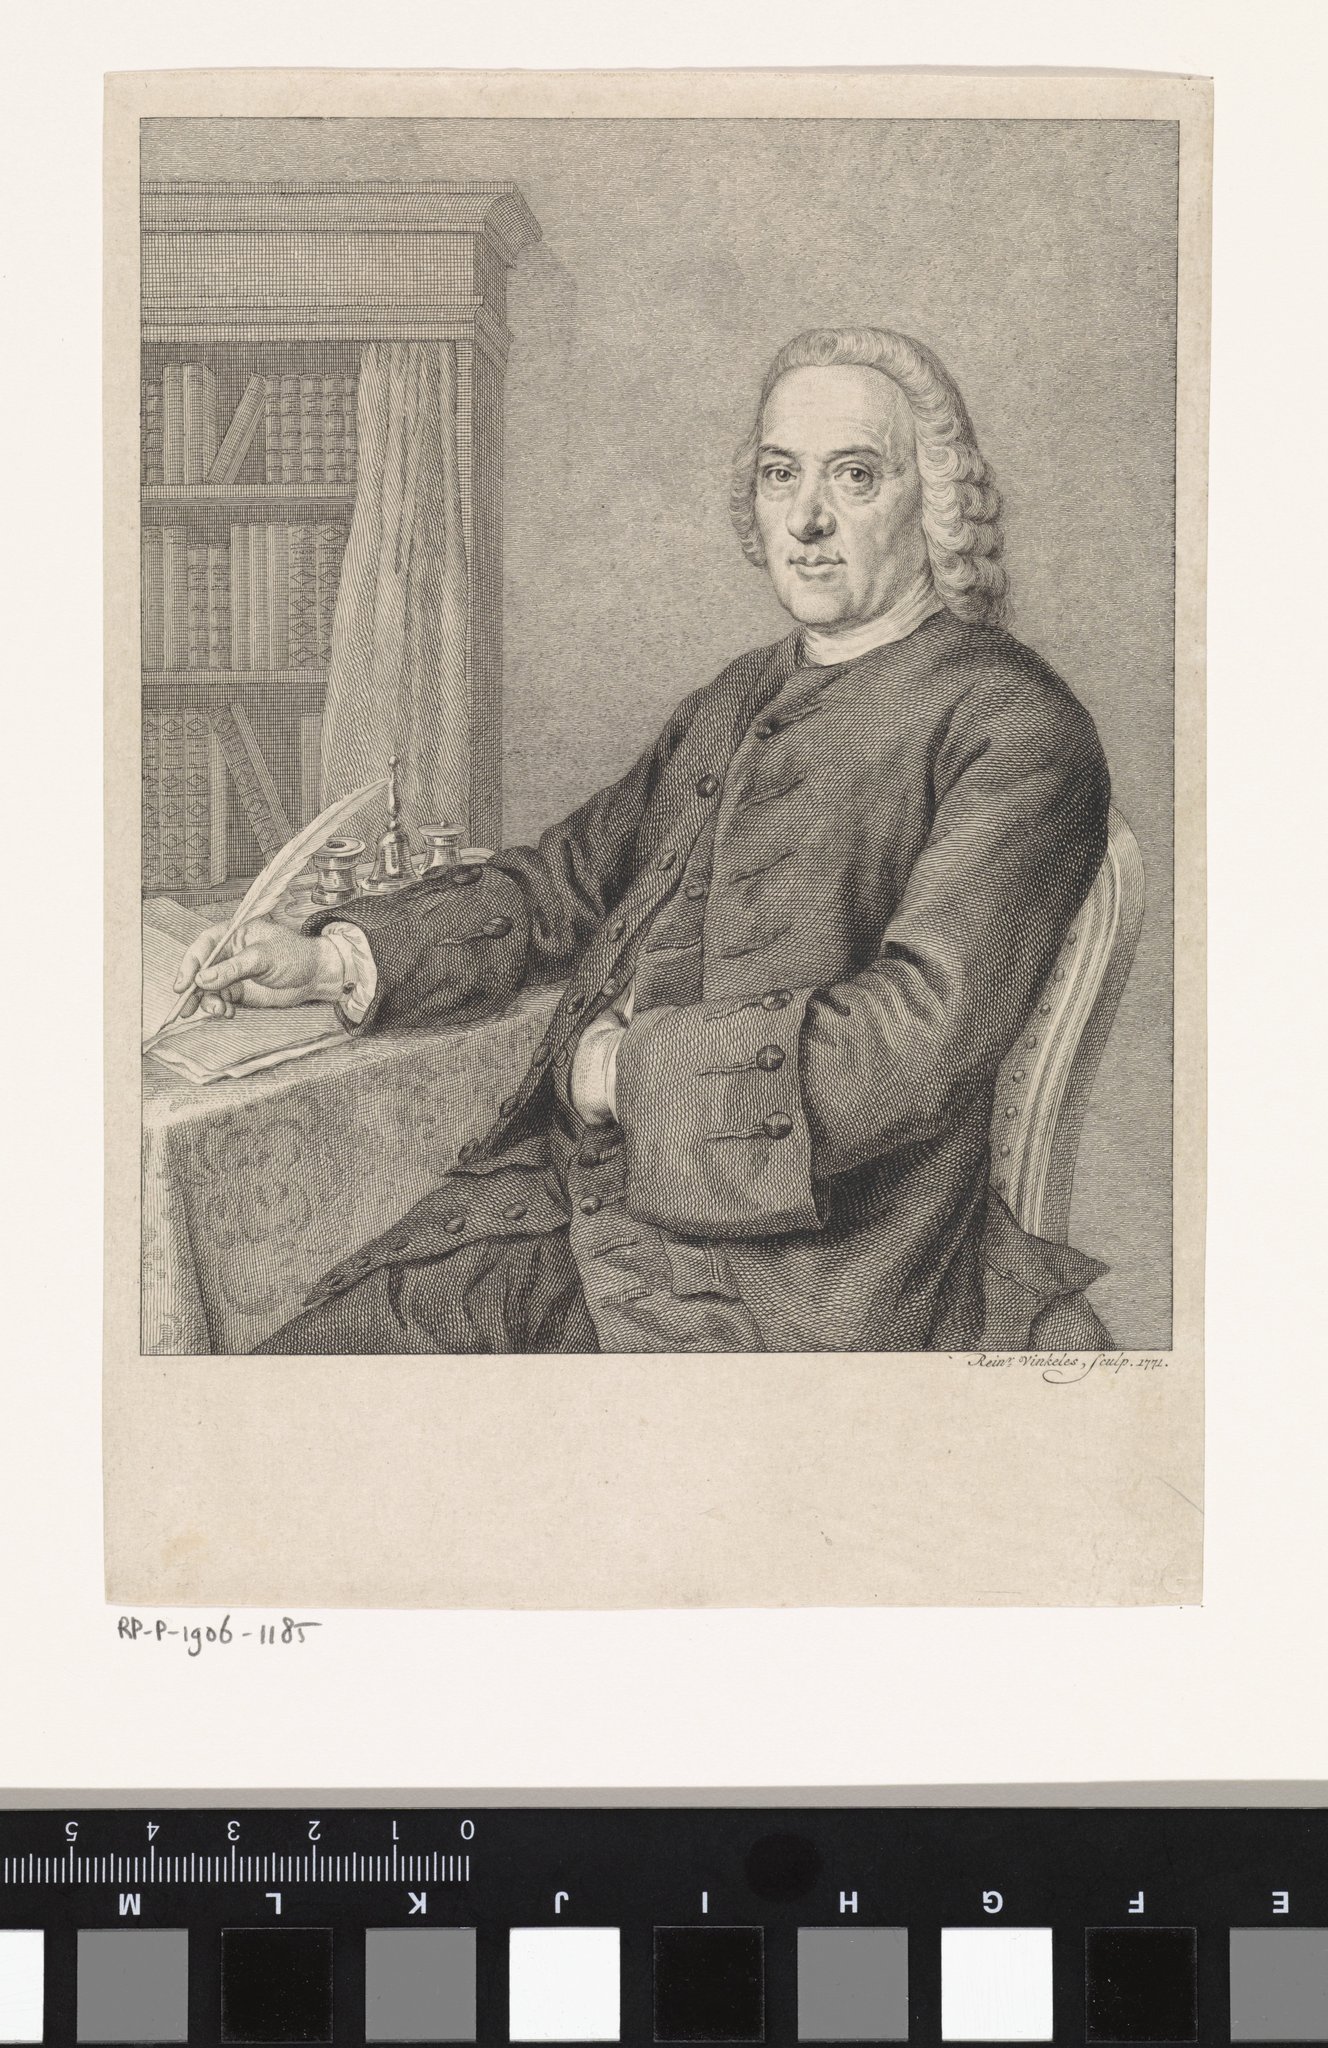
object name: print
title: Portret van Nikolaes Versteeg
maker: reinier vinkeles (i)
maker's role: draughtsman, print maker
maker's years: 1741-1816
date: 1771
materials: paper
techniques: engraving, etching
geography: amsterdam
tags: nikolaes versteeg, writing-table, writing-desk, quill, study; 'studiolo'; library, writing accessories, paper (writing material)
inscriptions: collector's mark: Lugt 2228, collector's mark: Lugt 1120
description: Portret van de Rotterdamse dichter Nikolaes Versteeg, op 67-jarige leeftijd, in zijn werkkamer, met een schrijfveer in de hand. Op tafel een schrijfset en vellen papier. Tegen de achterwand staat een boekenkast.